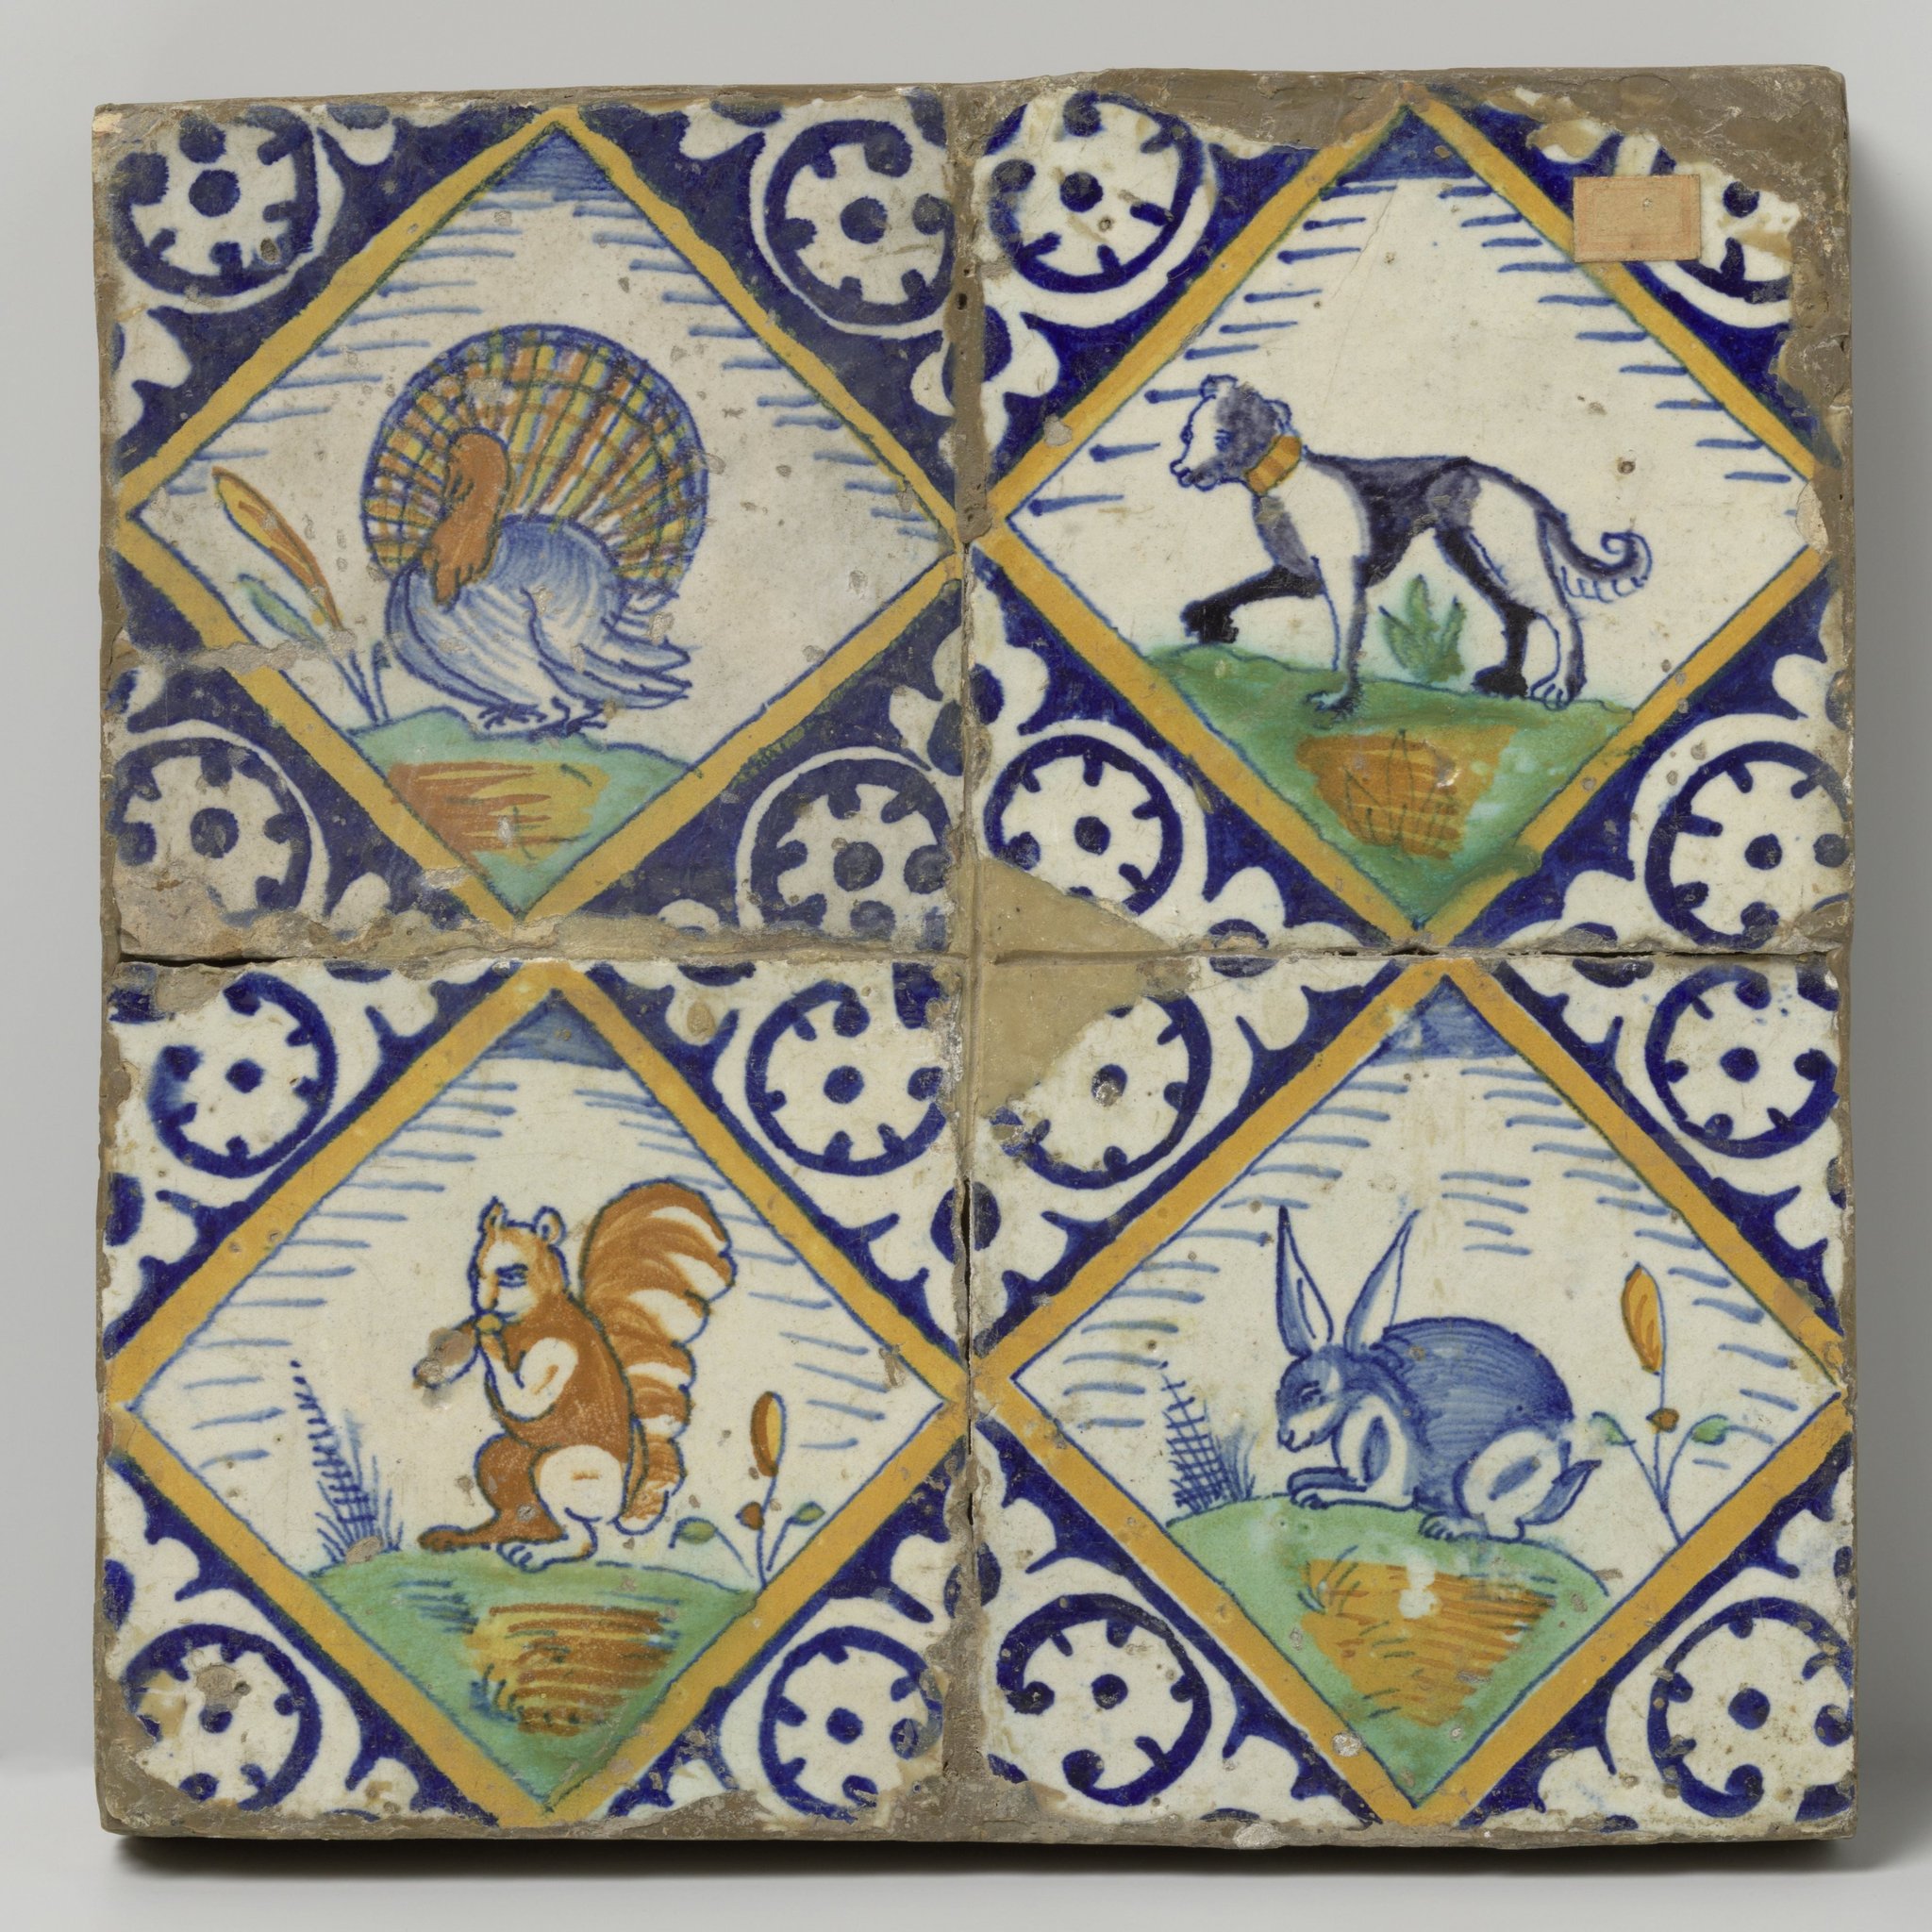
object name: tegelveld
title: Veld van vier tegels met dieren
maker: Anonymous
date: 1580-1625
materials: earthenware, glaze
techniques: maiolica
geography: netherlands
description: Veld van vier tegels (2 x 2) elk met een veelkleurig (blauw, oranje, geel, groen en paars) dier op een grond binnen een kwadraat. In de hoeken, ornament in vultechniek.